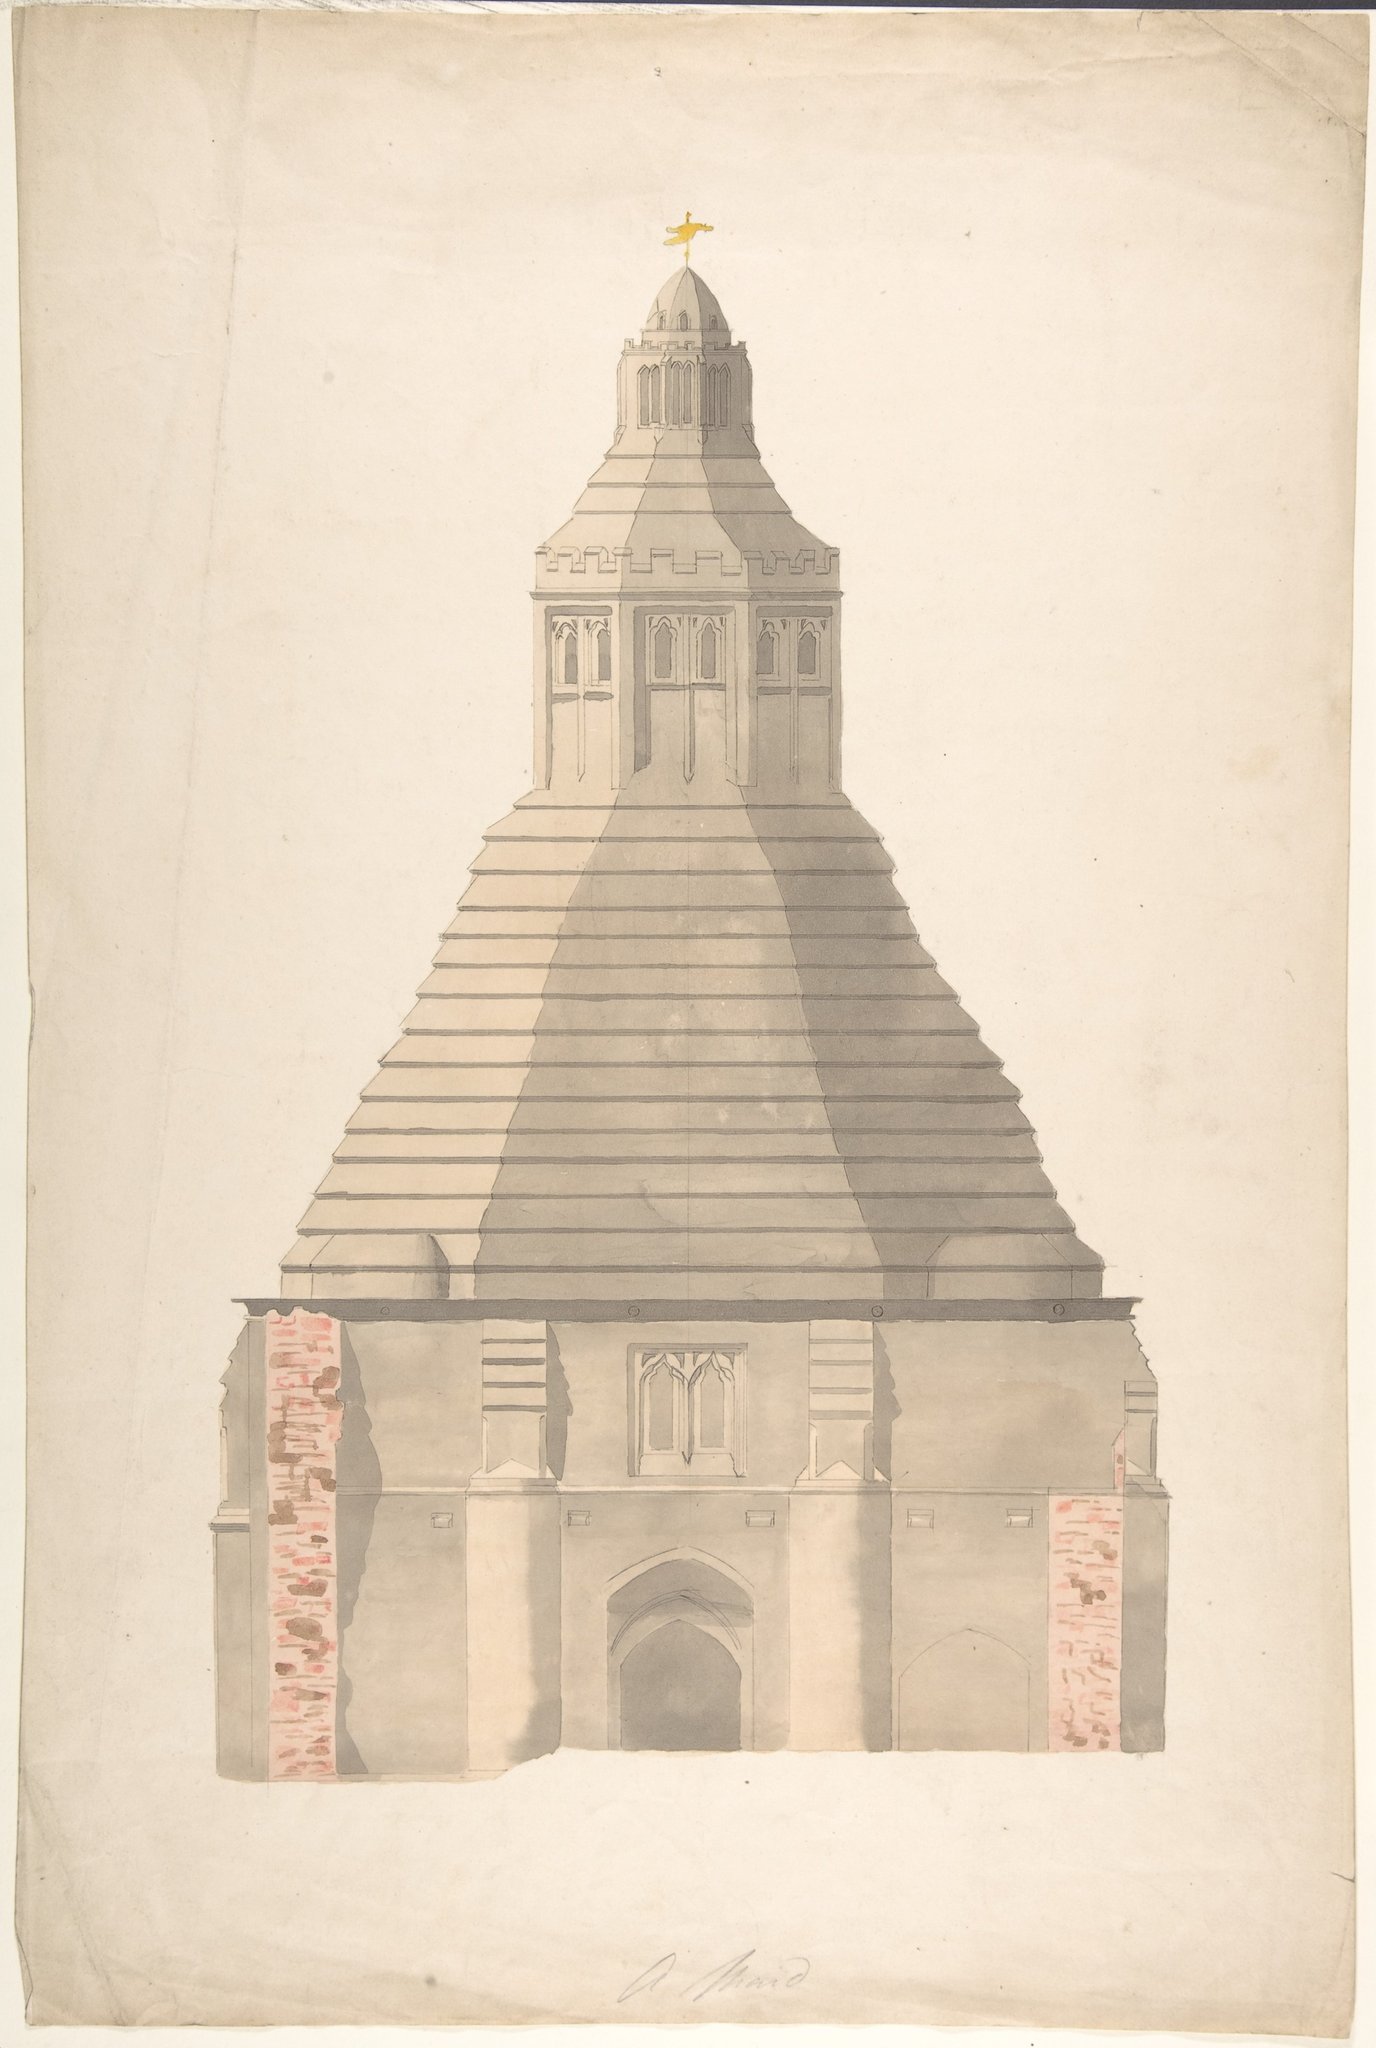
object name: drawing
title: The Abbot's Kitchen, Glastonbury Abbey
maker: anonymous, british, 19th century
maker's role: artist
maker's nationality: british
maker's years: 1800-1900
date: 1801-1900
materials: ink, watercolor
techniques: brush, pen, wash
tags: architecture,kitchens,abbeys